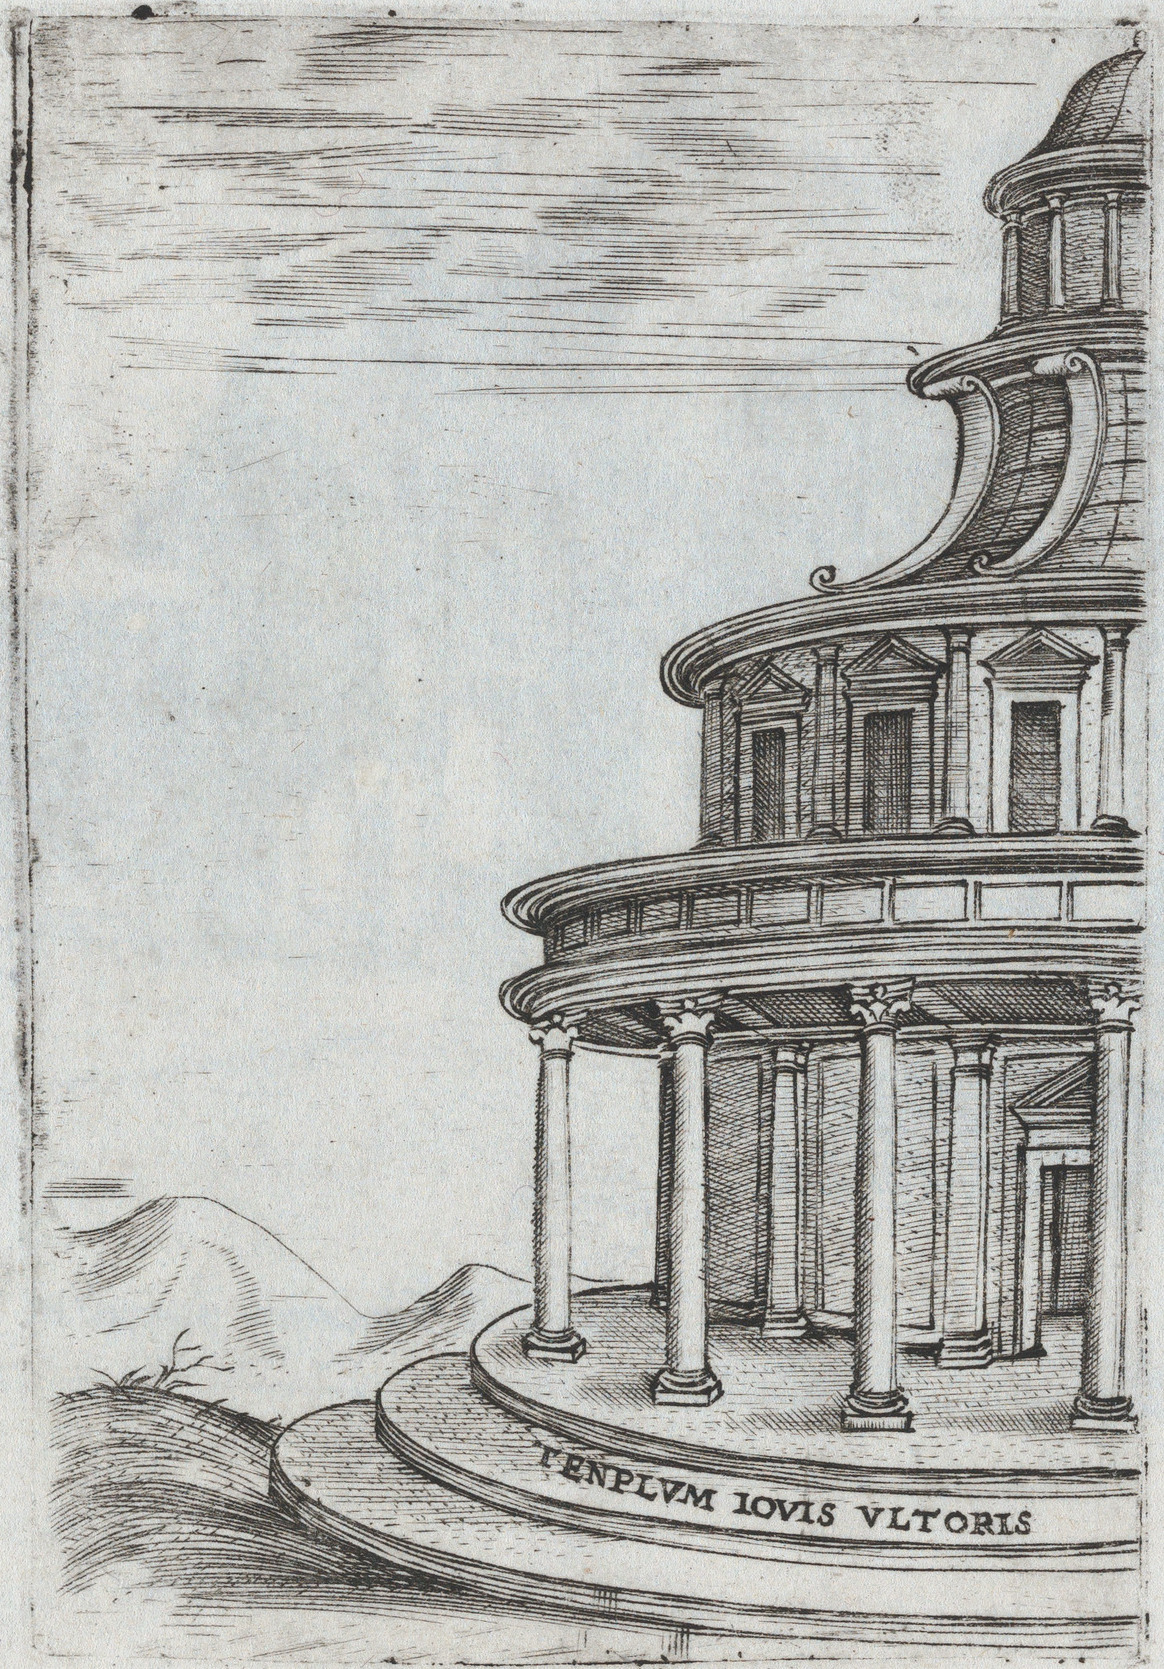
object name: album print ornament architecture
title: Teatrum Bordeos [Transitorium Caesaris in later editions], from a Series of Prints depicting (reconstructed) Buildings from Roman Antiquity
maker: monogrammist g.a. with the caltrop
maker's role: artist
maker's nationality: italian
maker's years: 1535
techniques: engraving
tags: buildings